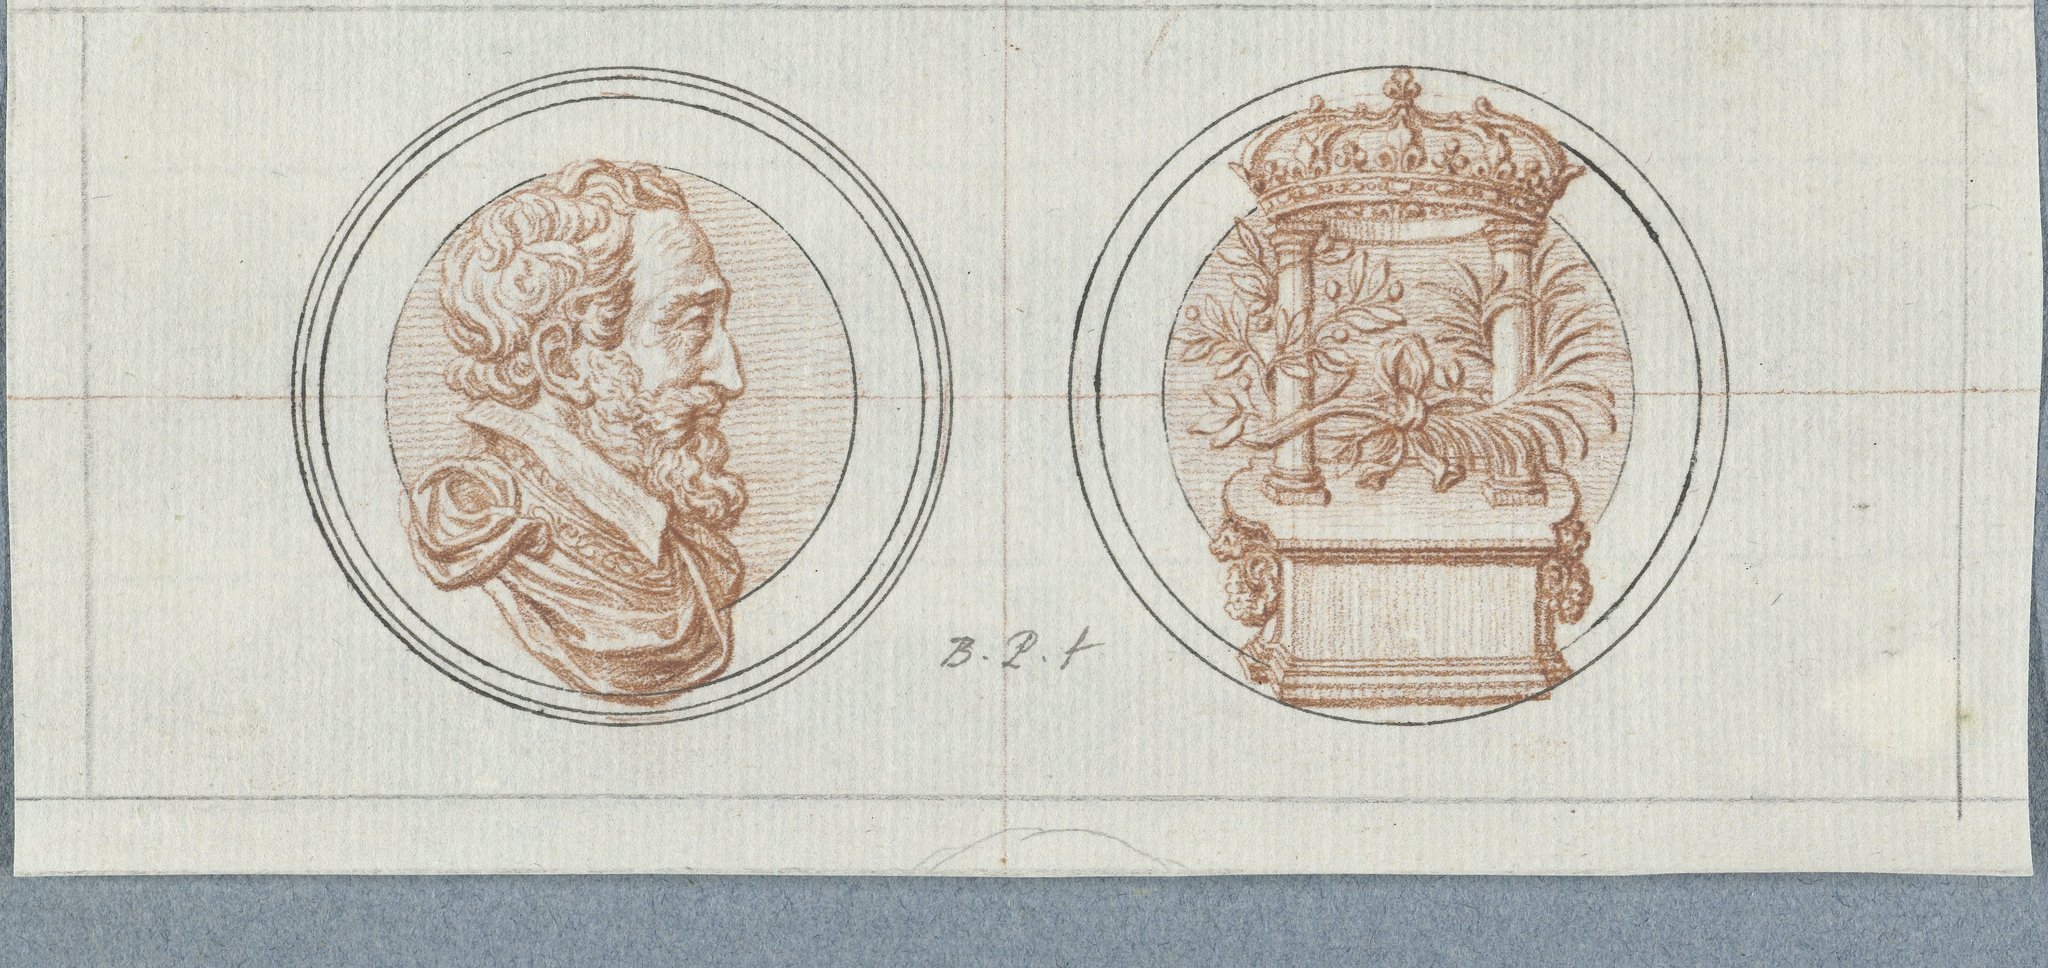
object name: design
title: Voor- en achterzijde van een penning op de Alliantie van Frankrijk met de Zwitsers in 1602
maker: bernard picart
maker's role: draughtsman, print maker, publisher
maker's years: 1673-1733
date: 1683-1733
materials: chalk, ink, paper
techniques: pen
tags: hendrik iv (koning van frankrijk en navarra), historical persons, medal (considered as a piece of sculpture, regardless of its specific function), alliance, league, union, foedus, france, switzerland